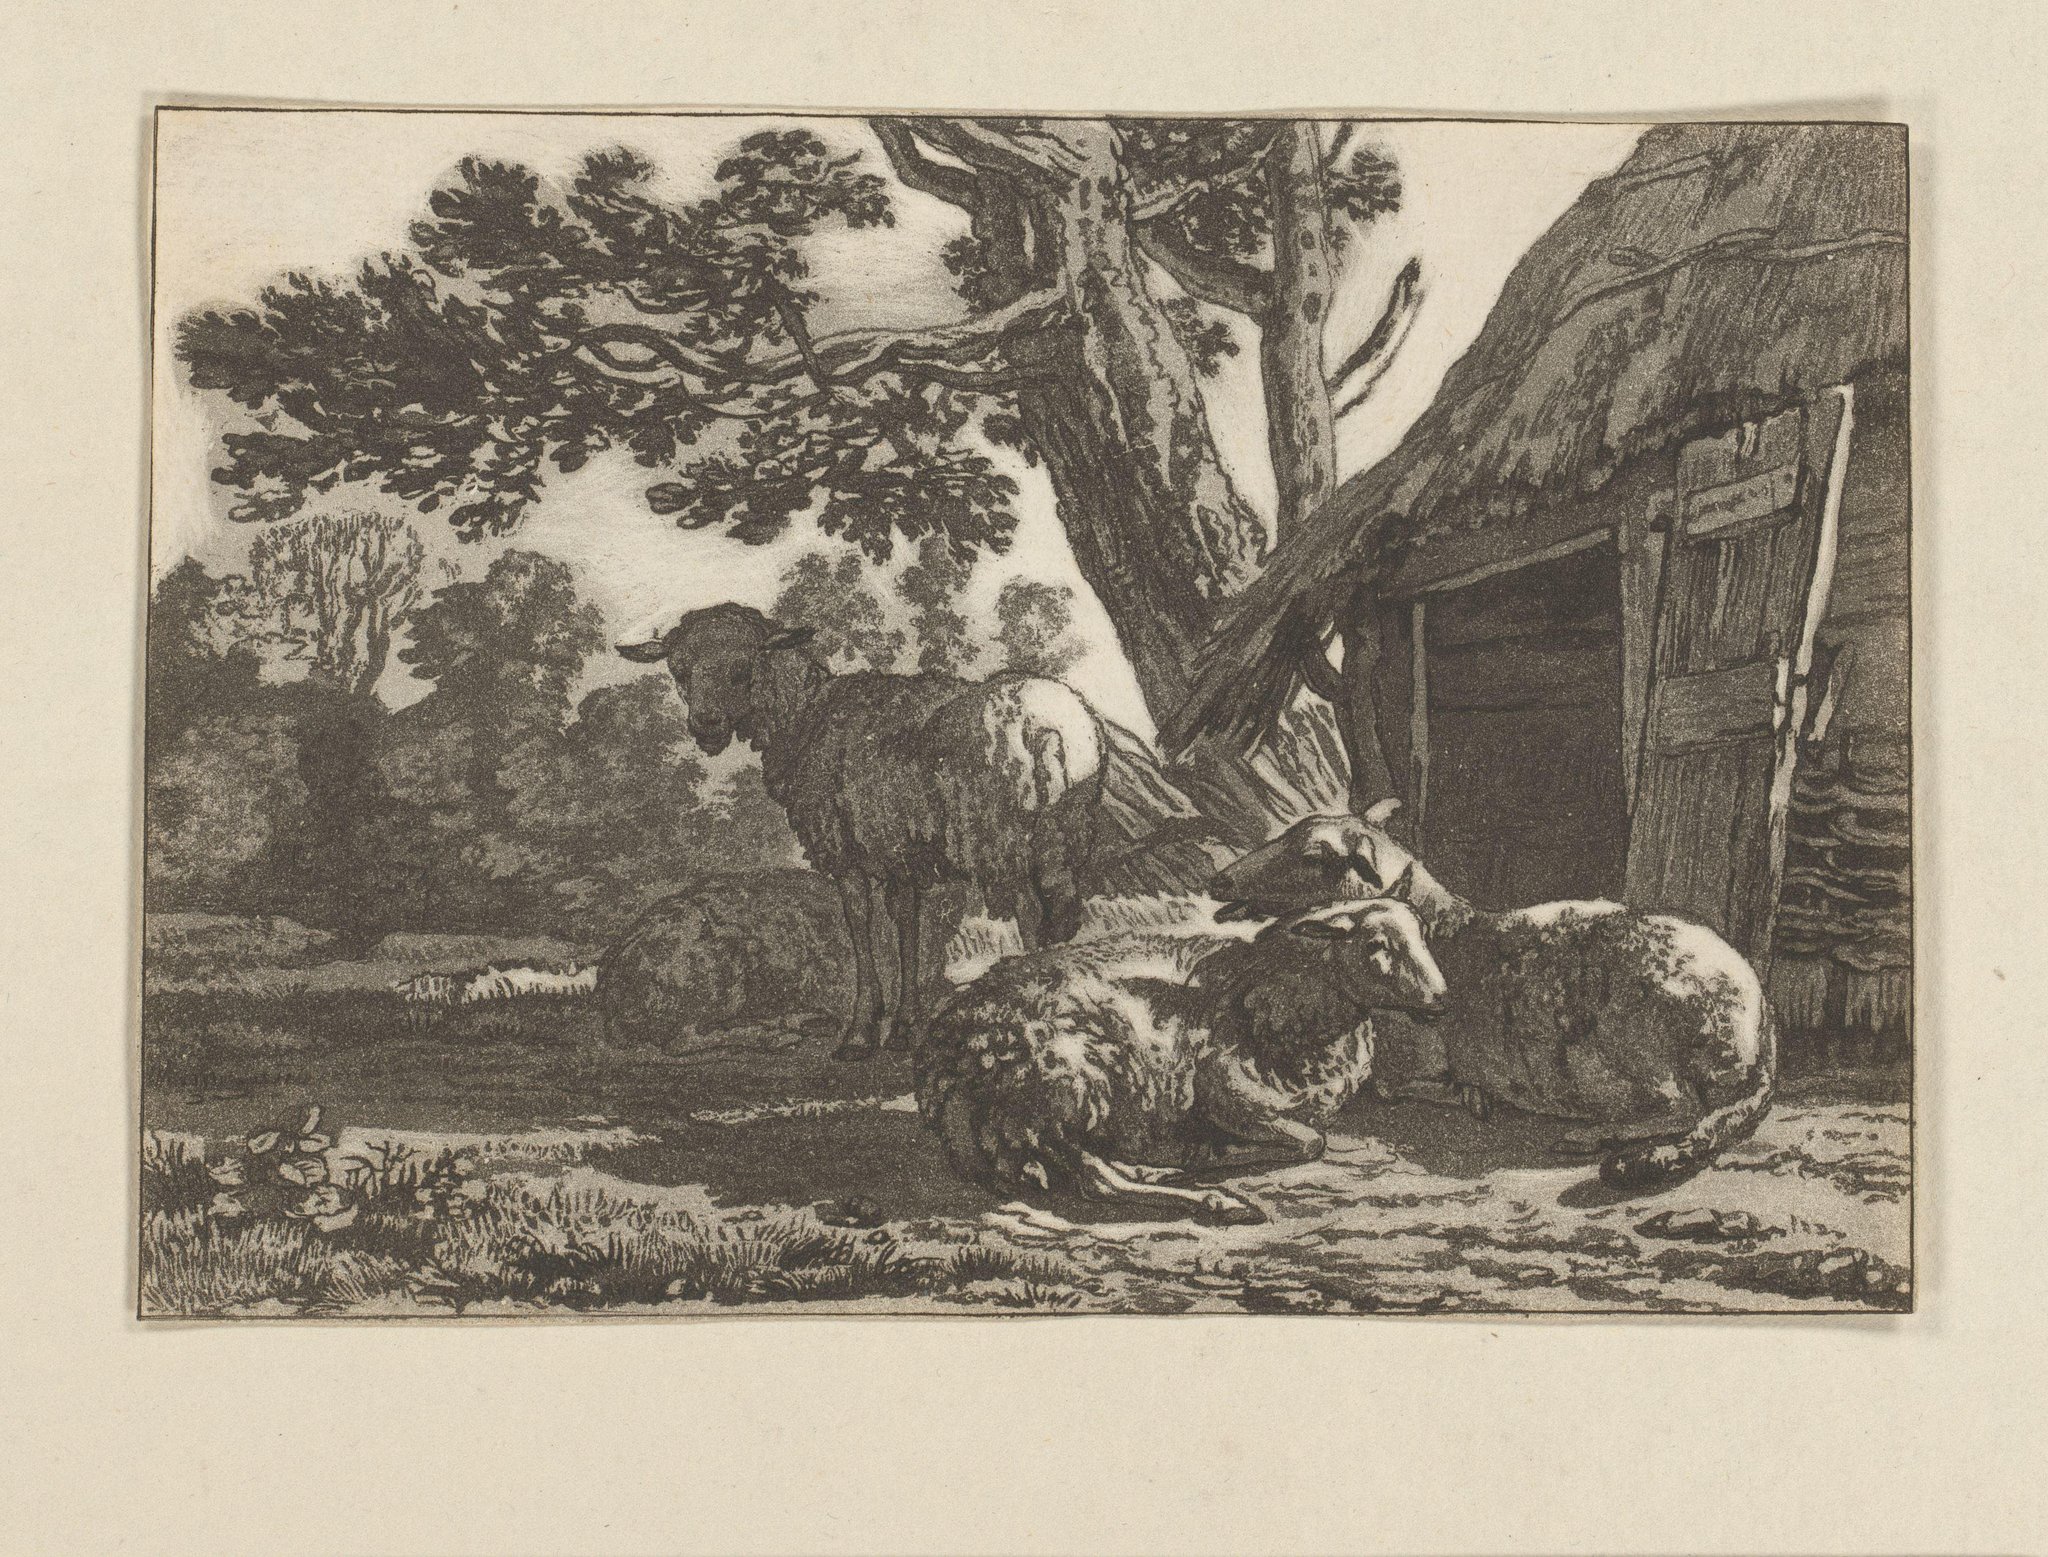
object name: print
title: Schaapskooi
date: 1781-1787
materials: paper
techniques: transfer, print drawing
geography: amsterdam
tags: sheep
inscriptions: collector's mark: ‘RIJKS / MUSM’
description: Vier schapen bij de geopende schaapskooi. De prent ligt los in een album, zie blad 44.